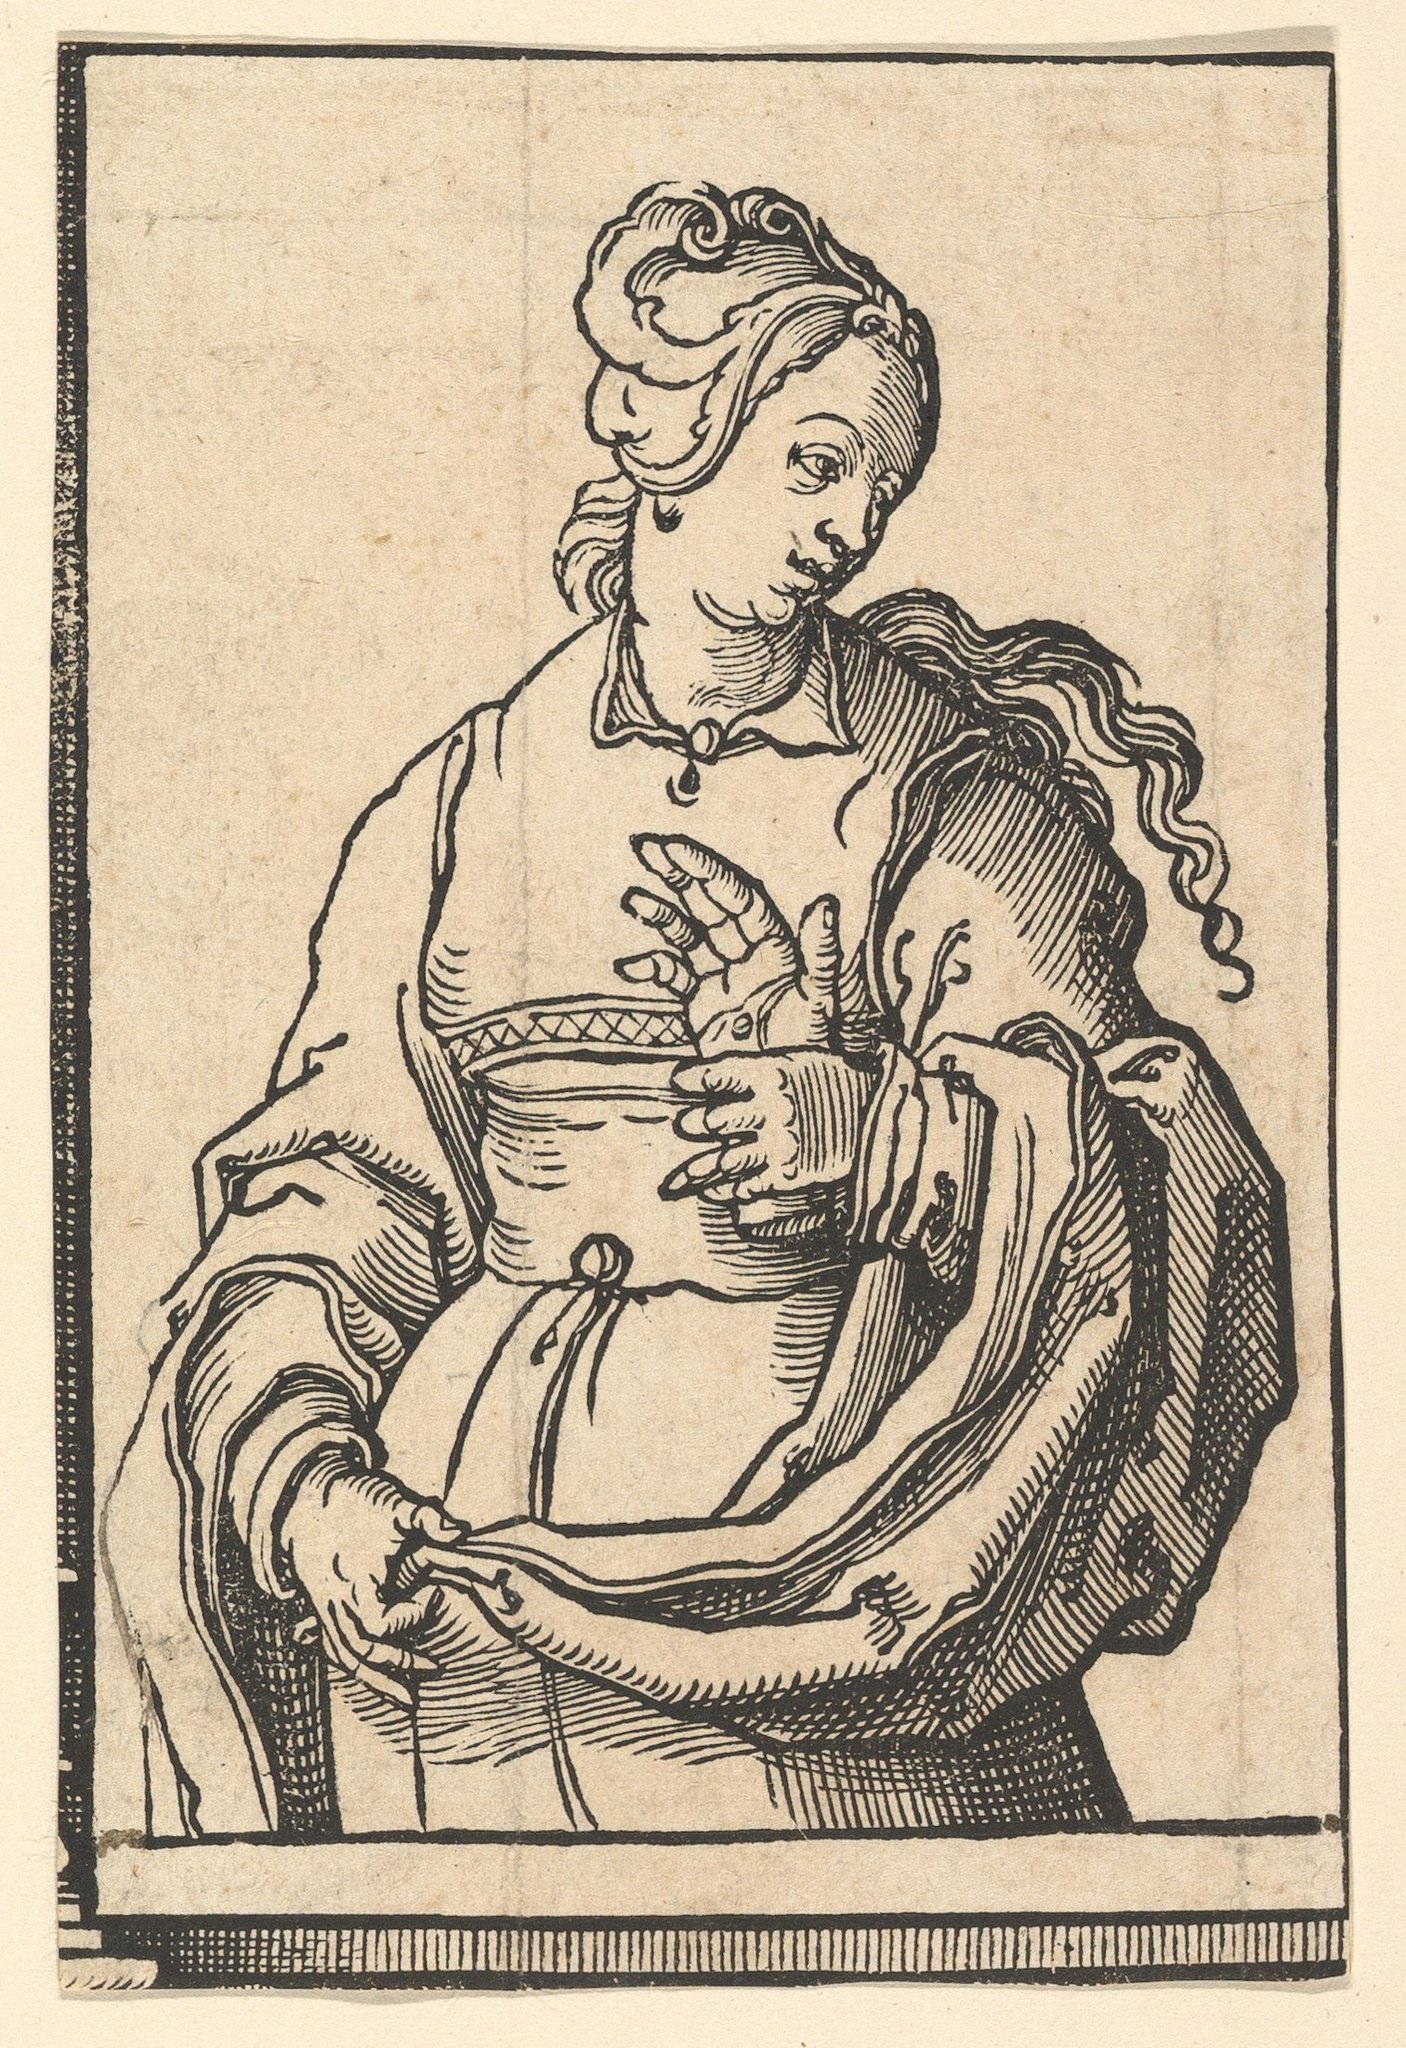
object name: print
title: Tiburtine Sibyl, from the series of Sibyls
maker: lucas van leyden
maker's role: artist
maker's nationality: netherlandish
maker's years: 1494-1533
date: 1530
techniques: woodcut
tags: hands,sibyl